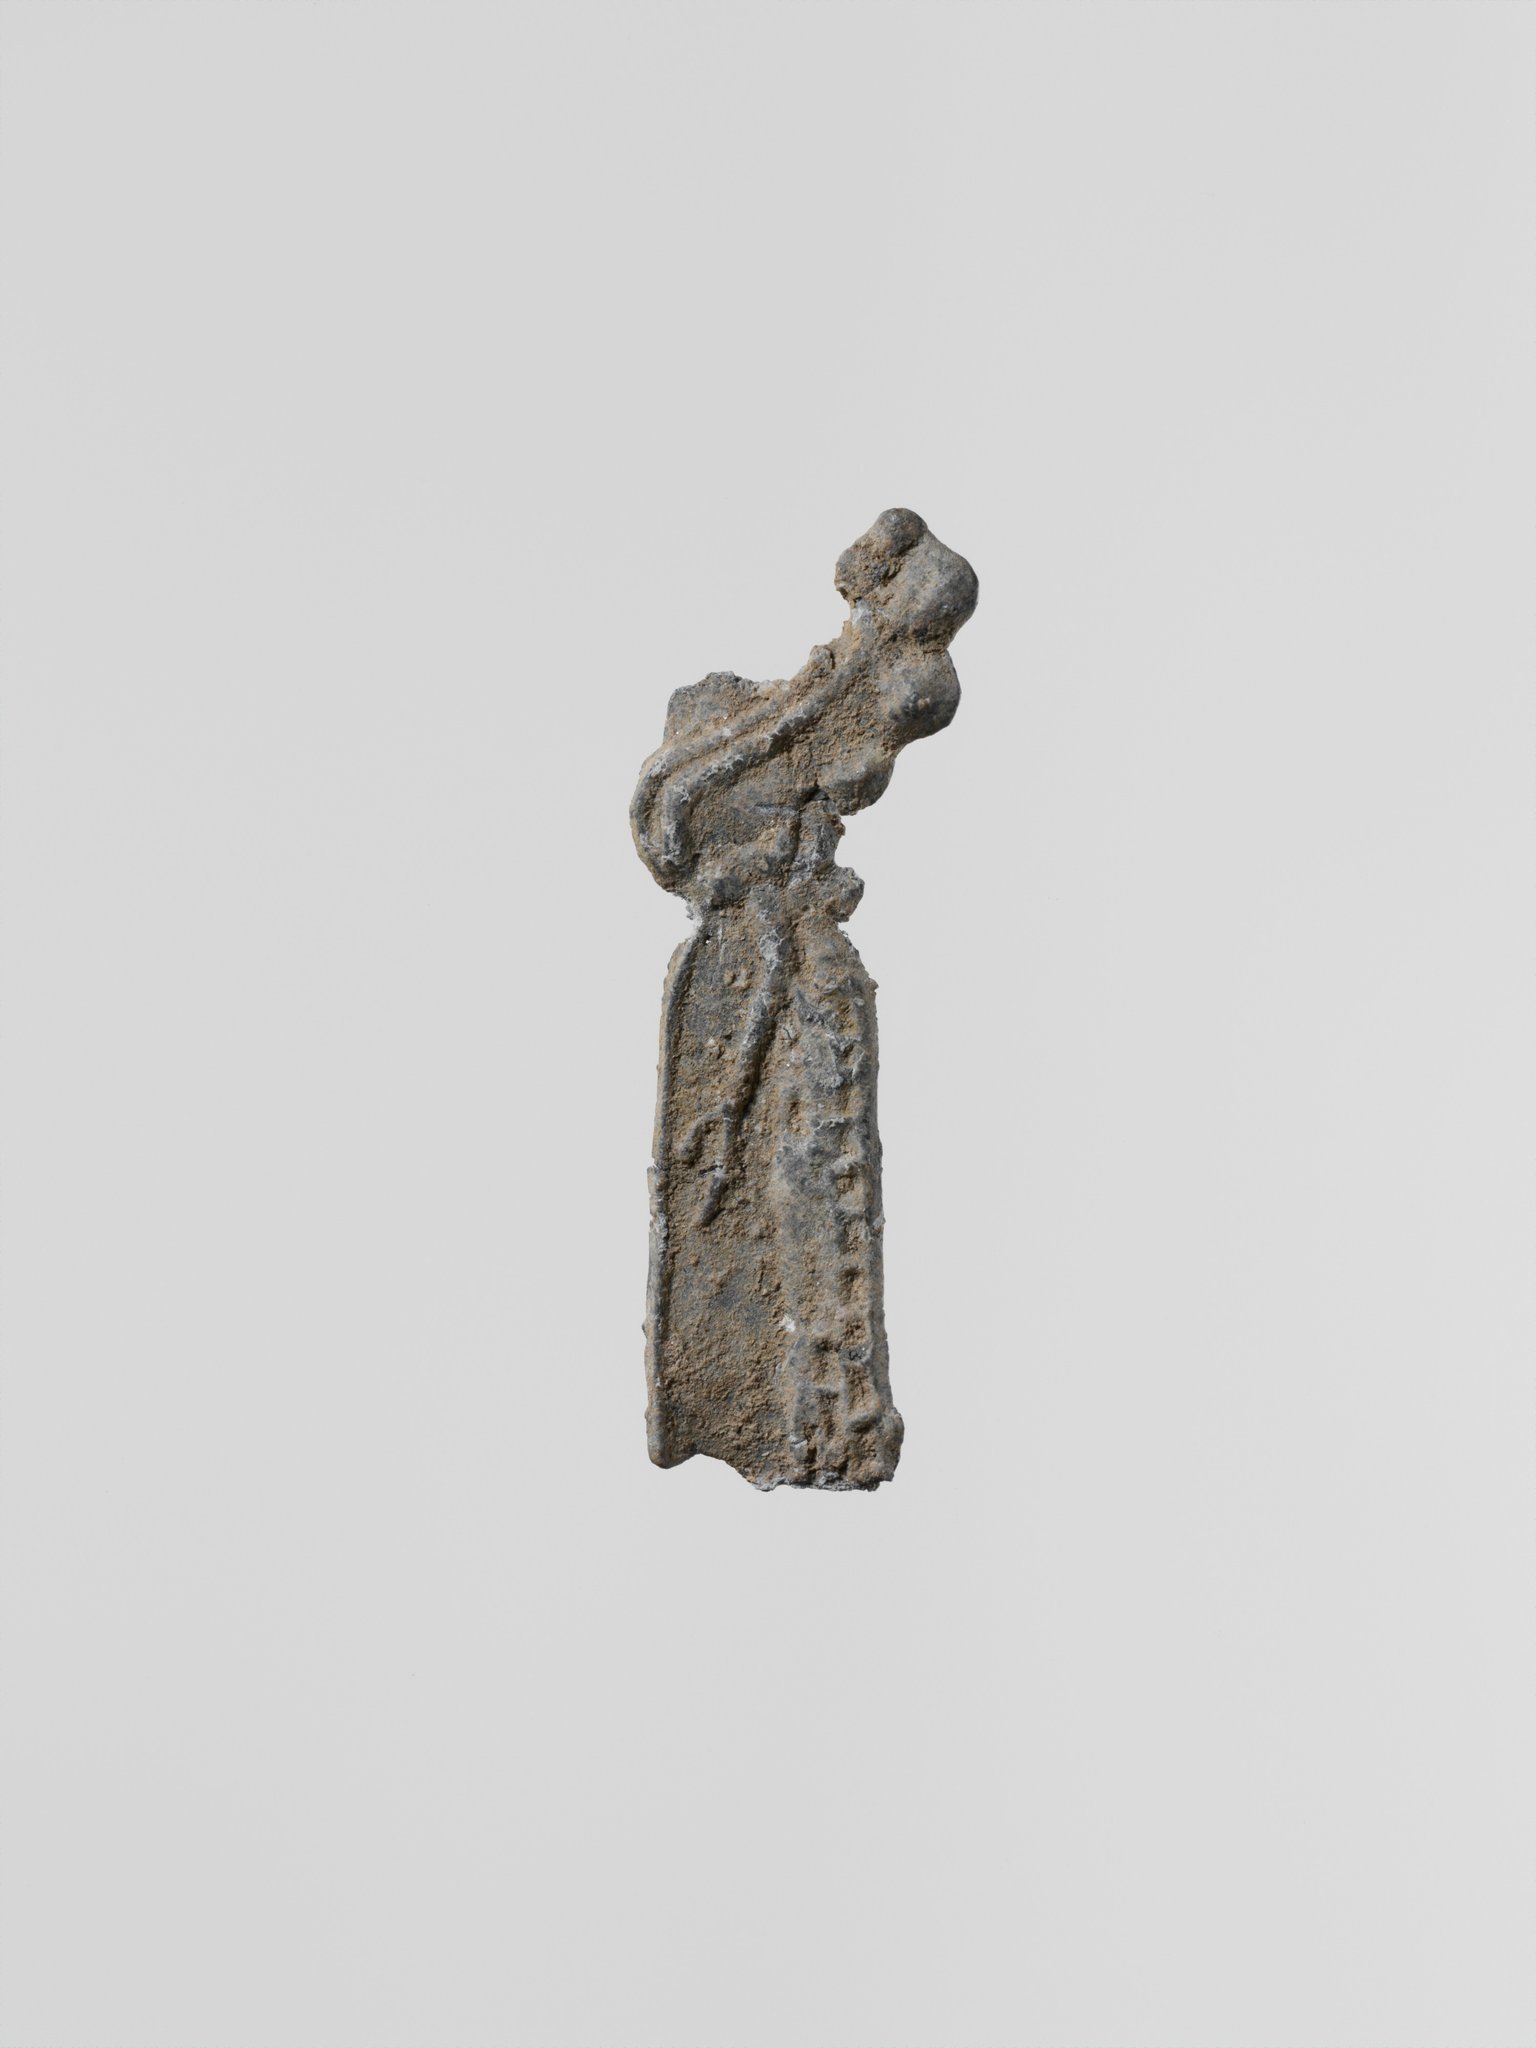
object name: statuette of artemis orthia winged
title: Statuette of Artemis Orthia-8, winged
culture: greek, laconian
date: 7000-30 BCE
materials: lead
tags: artemis